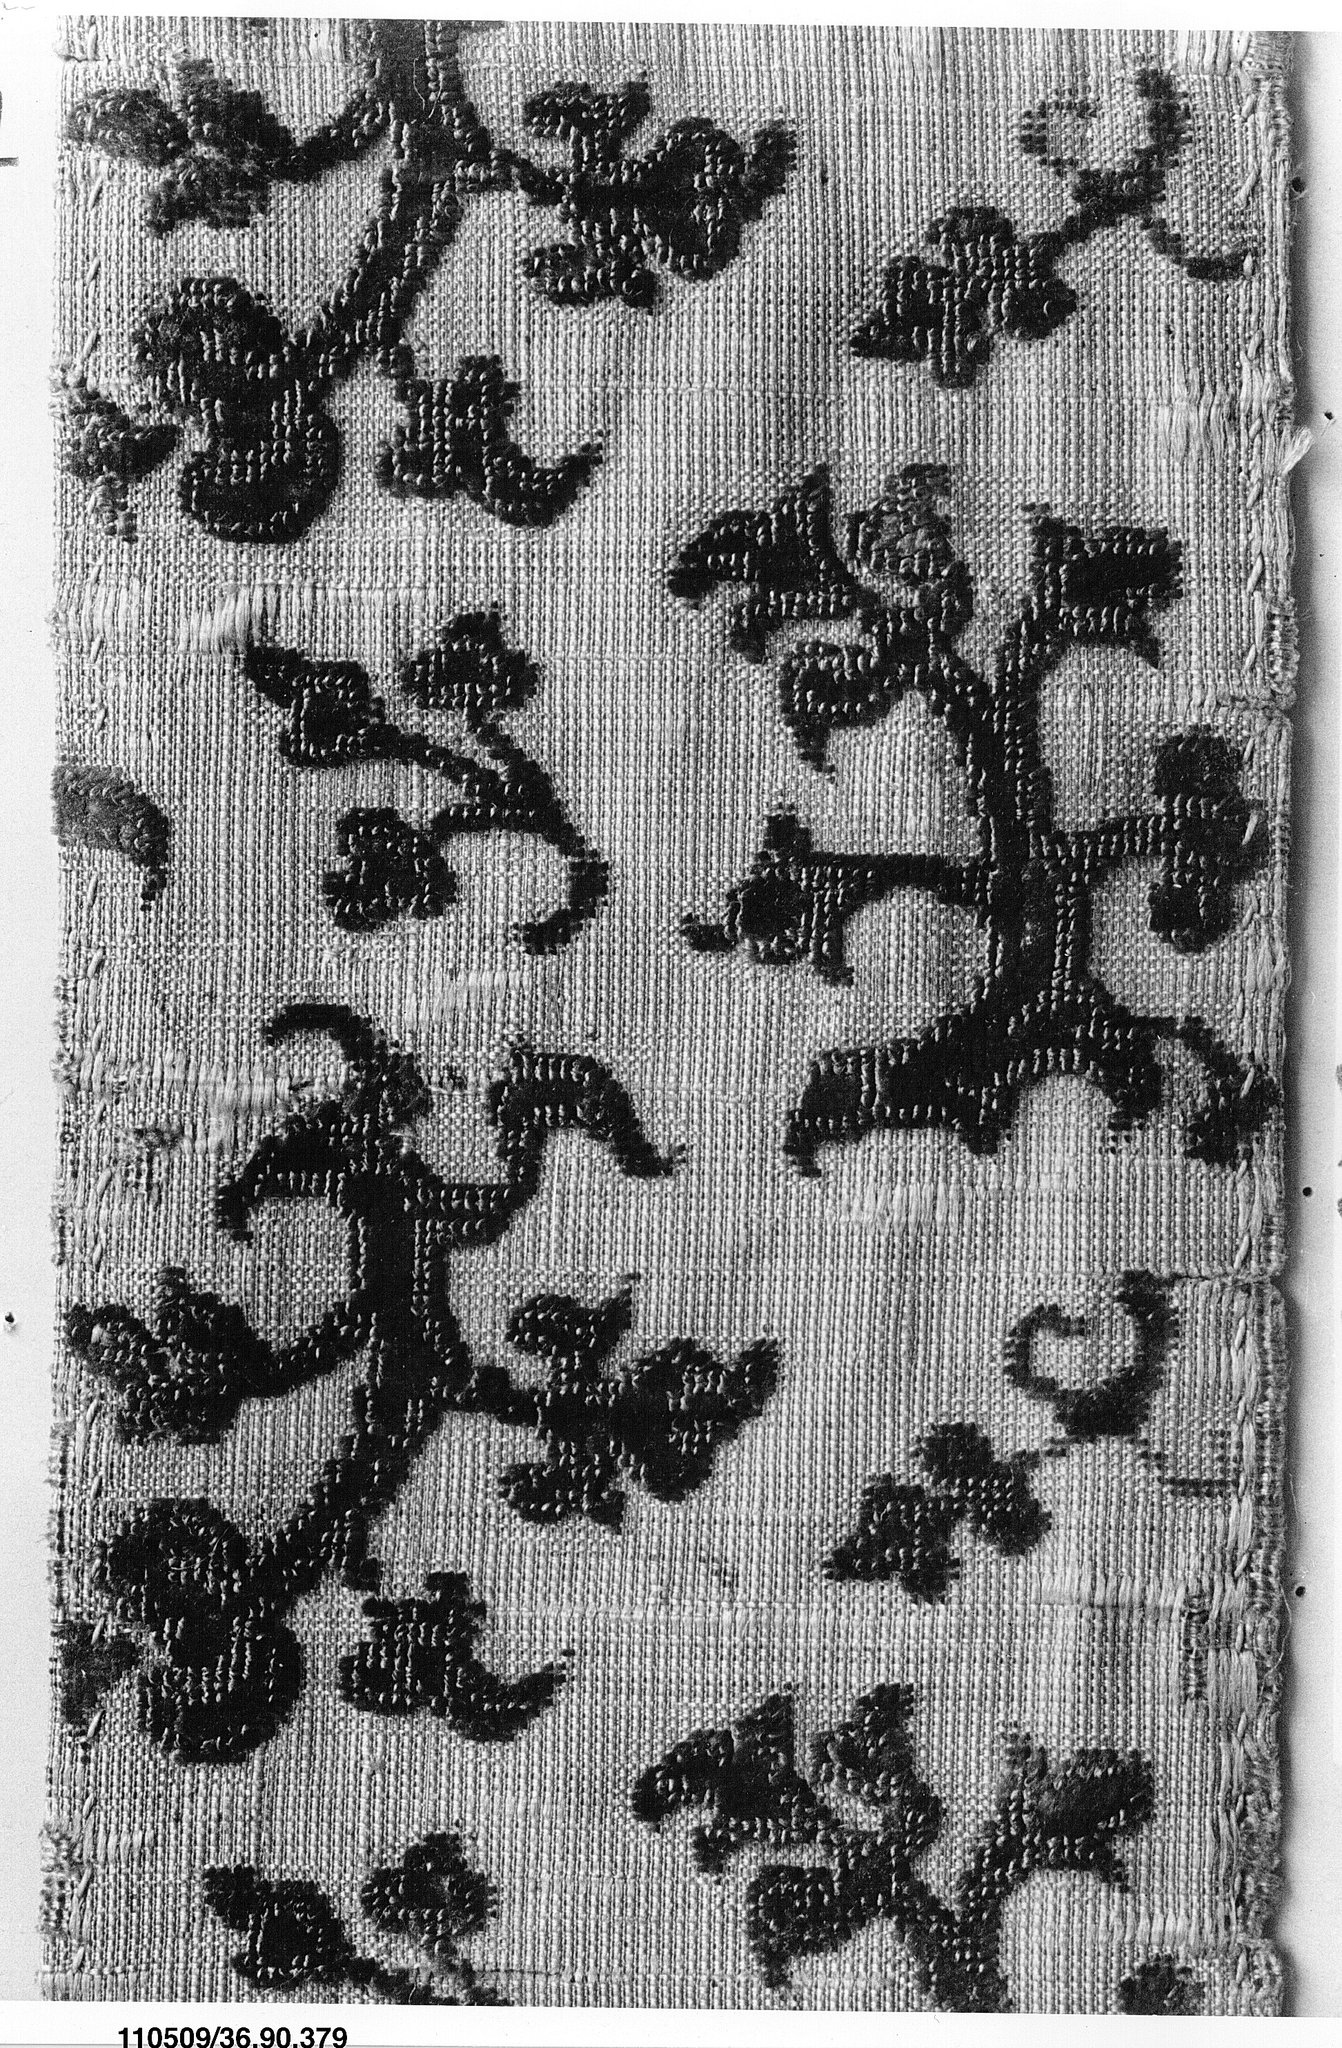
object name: piece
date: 1501-1700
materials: metal thread, silk